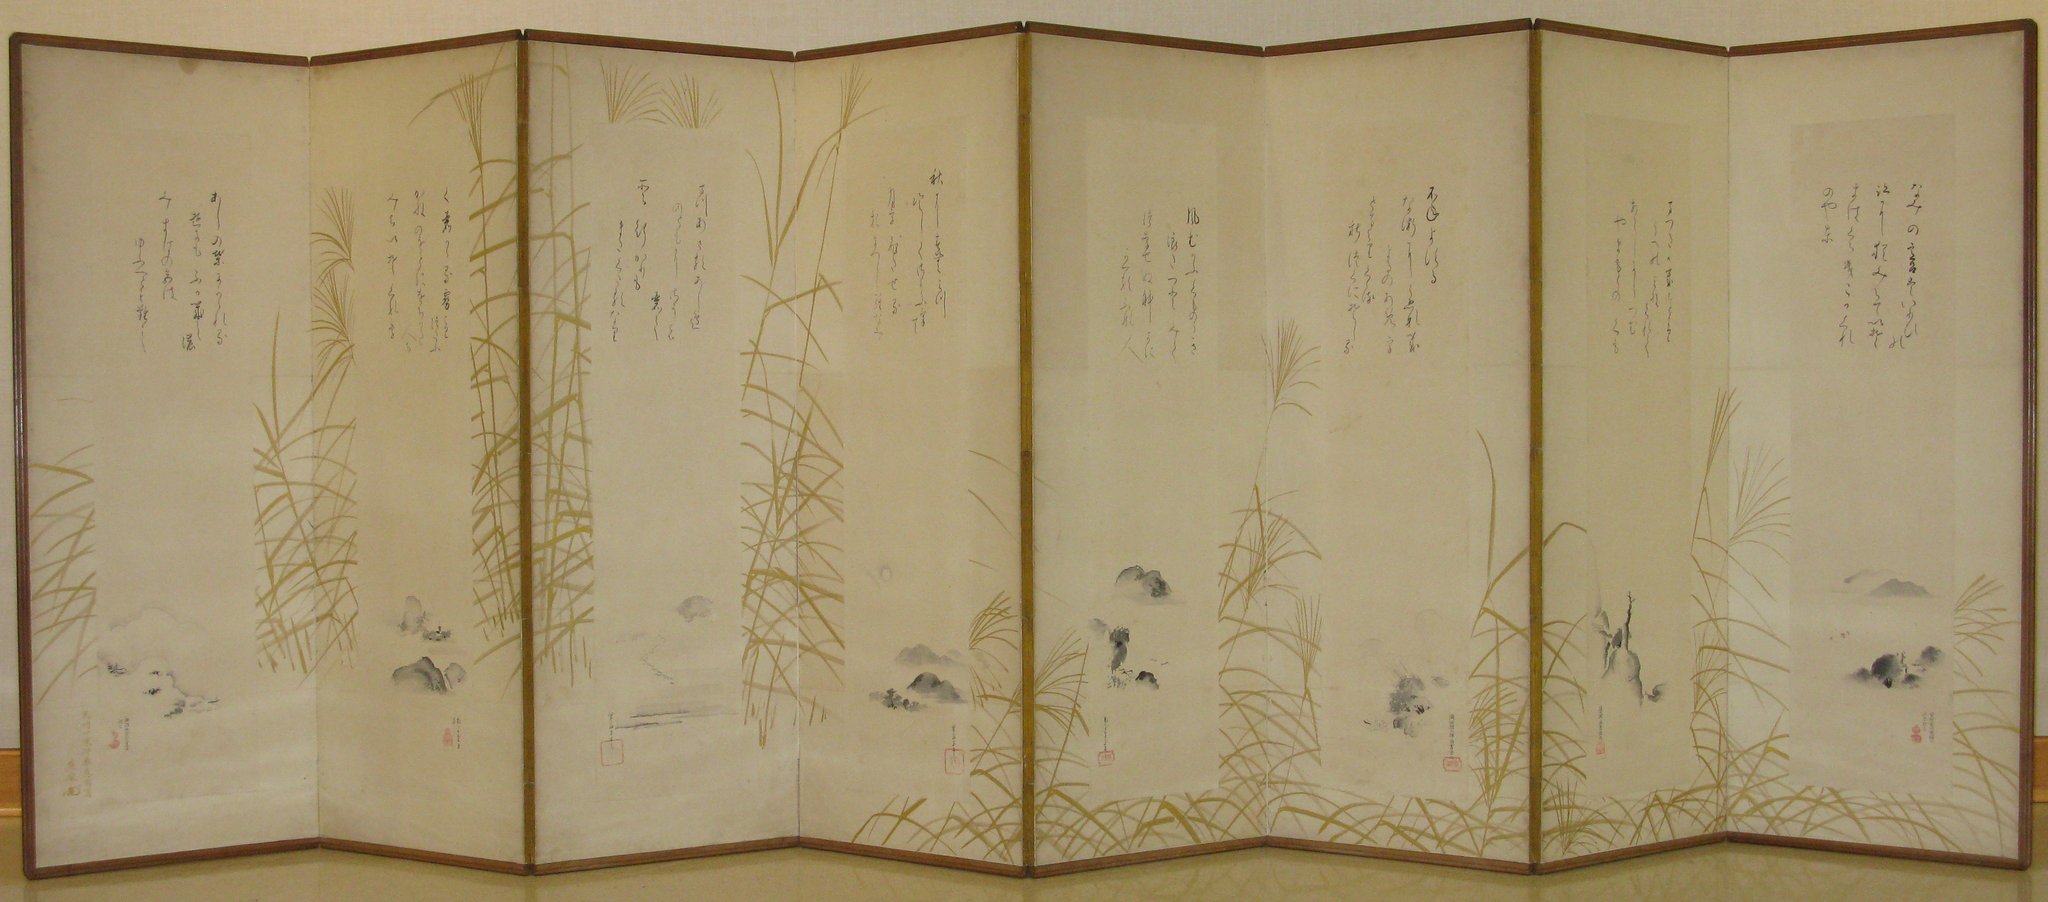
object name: screen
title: Eight Views of Xiao and Xiang Rivers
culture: japanese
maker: maruyama ōkyo 円山応挙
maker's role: artist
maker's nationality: japanese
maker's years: 1733-1795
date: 1767-1800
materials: gold, ink, panel, paper